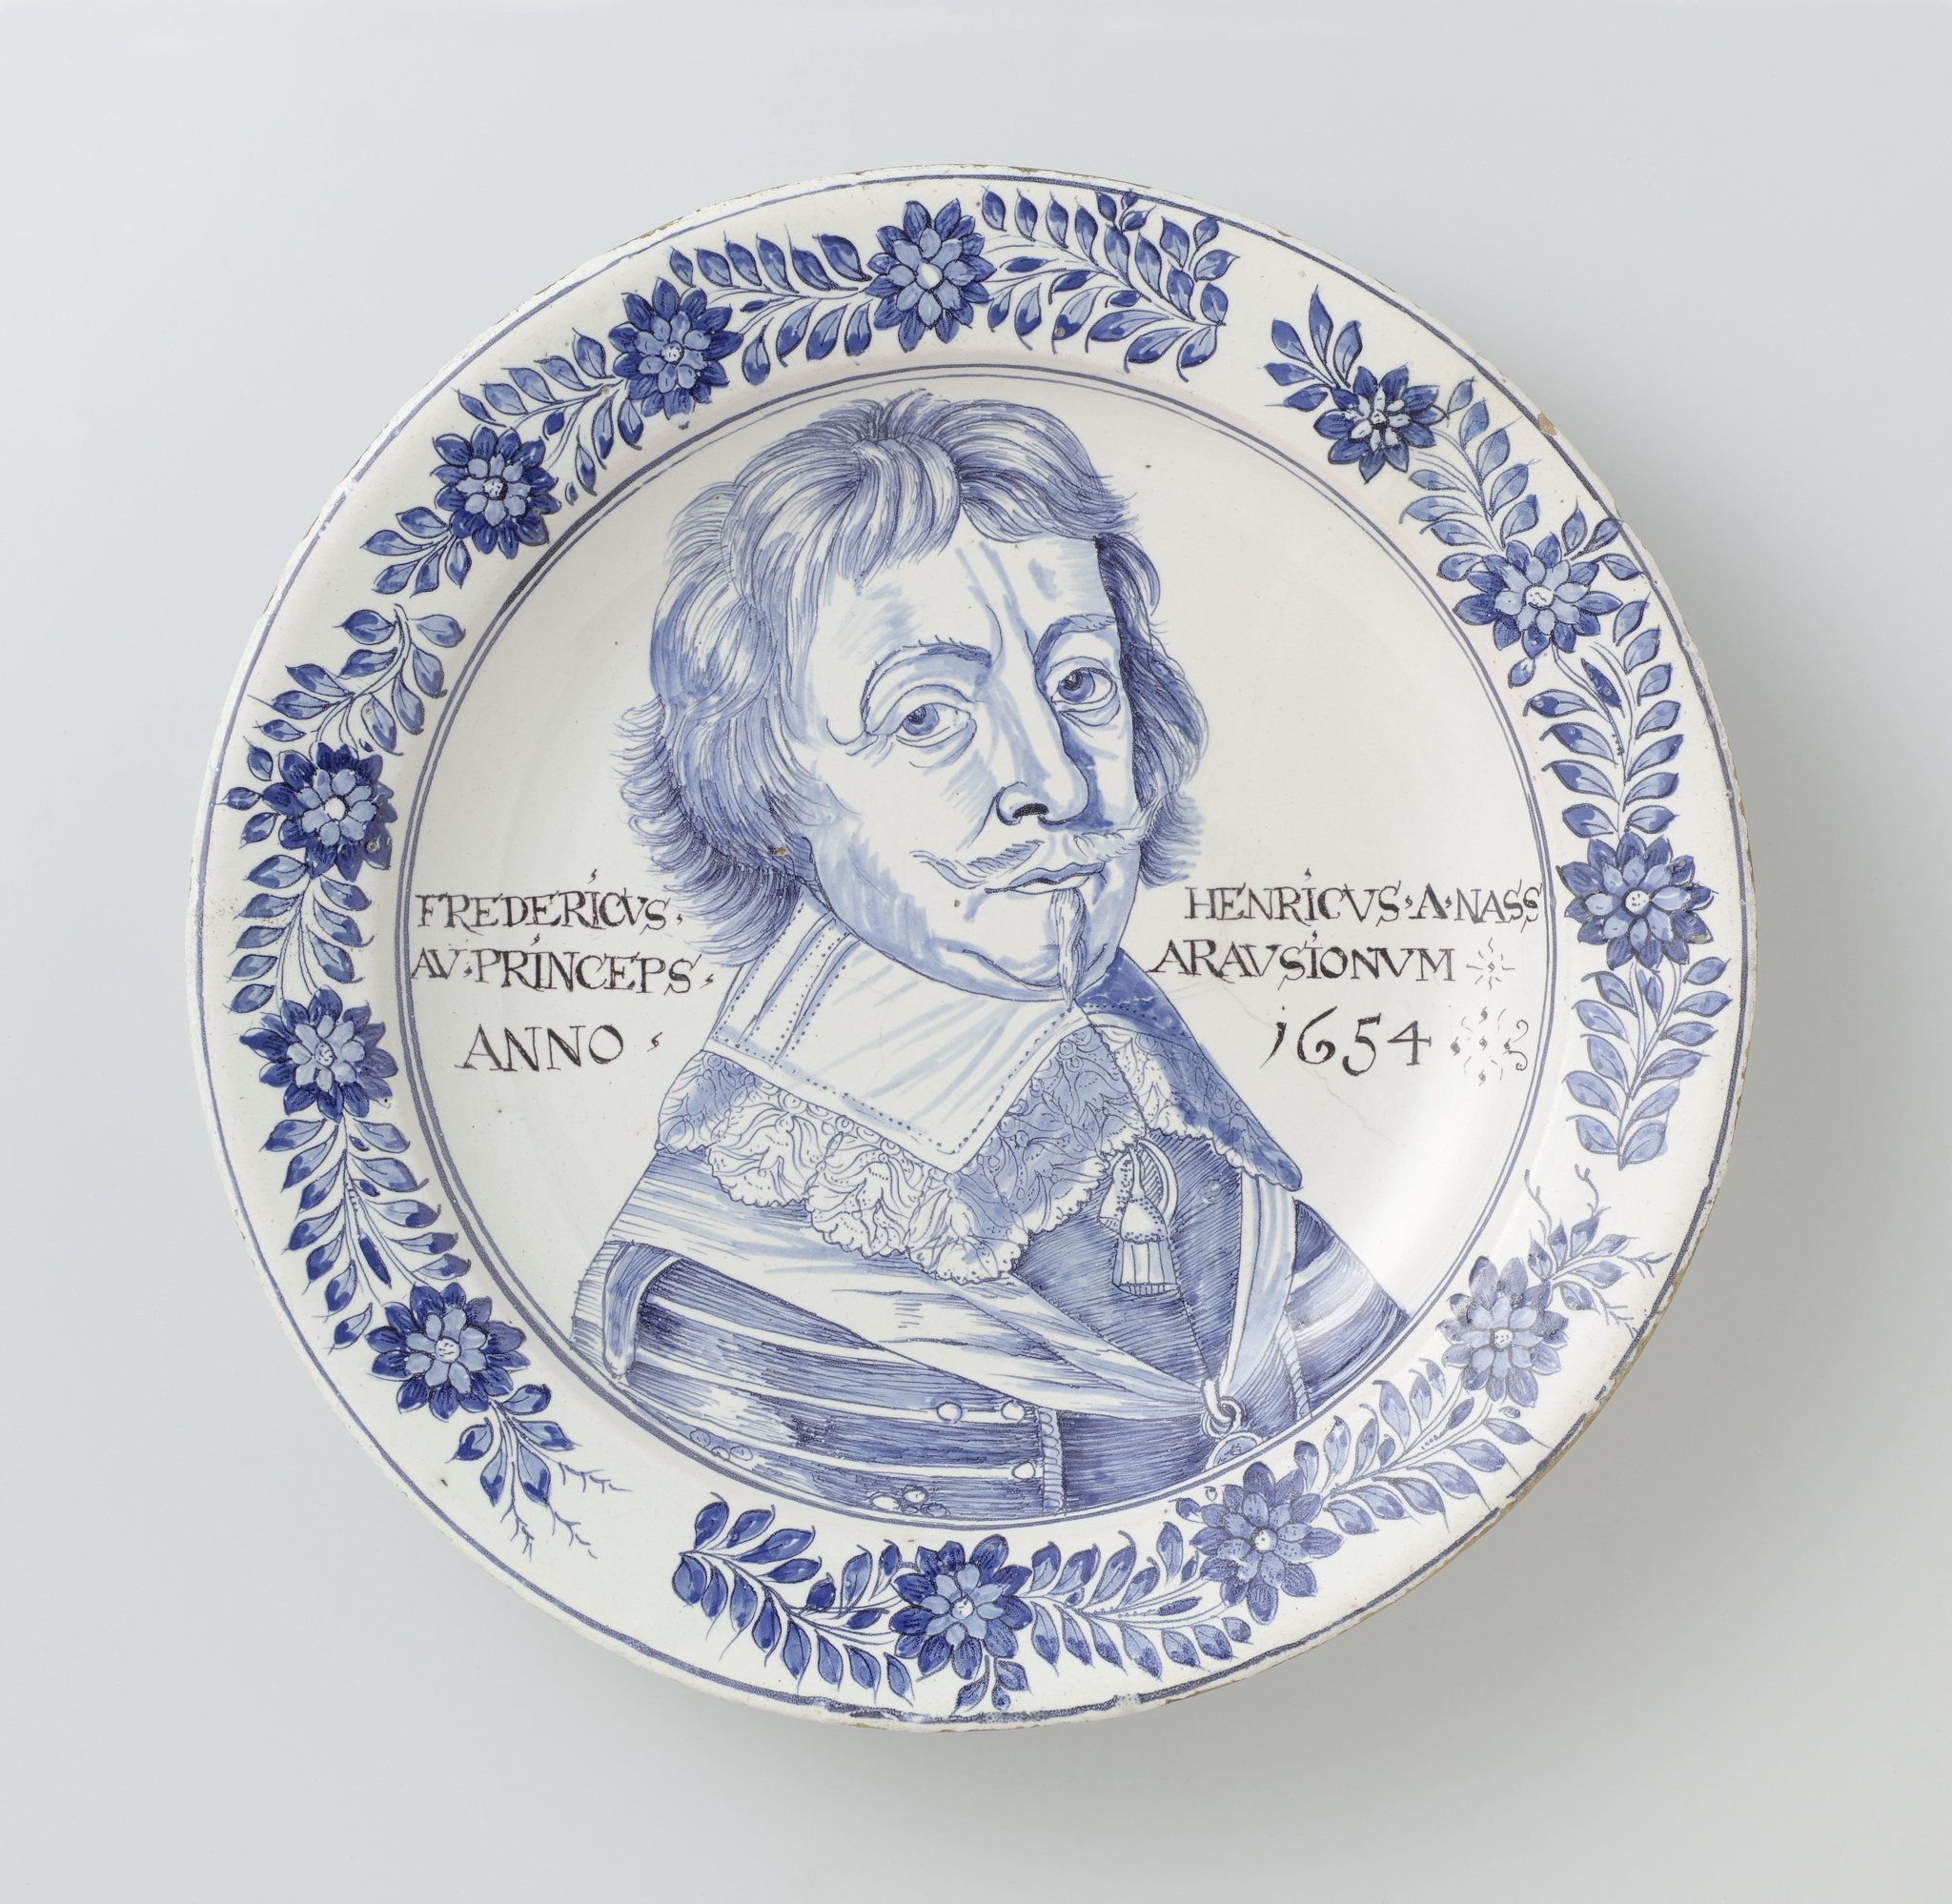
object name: platter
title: Dish with Stadtholder Frederick Henry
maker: willem jansz. verstraeten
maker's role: plateelbakker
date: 1654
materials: earthenware, glaze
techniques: painted, vitrification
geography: haarlem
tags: the hague, frederick henry (prince of orange), prince, historical persons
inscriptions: signature and date: ‘1654’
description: Schotel van faience met in de glazuur beschilderd portret in blauw en paars van Frederik Hendrik van Nassau, Prins van Oranje, naar een prent van I. van Meurs naar G. van Honthorst. De schotel met tekst: FREDERICVS HENRICVS*NASSAV.PRINCEPS.ARAVSIONVM*ANNO.1654.